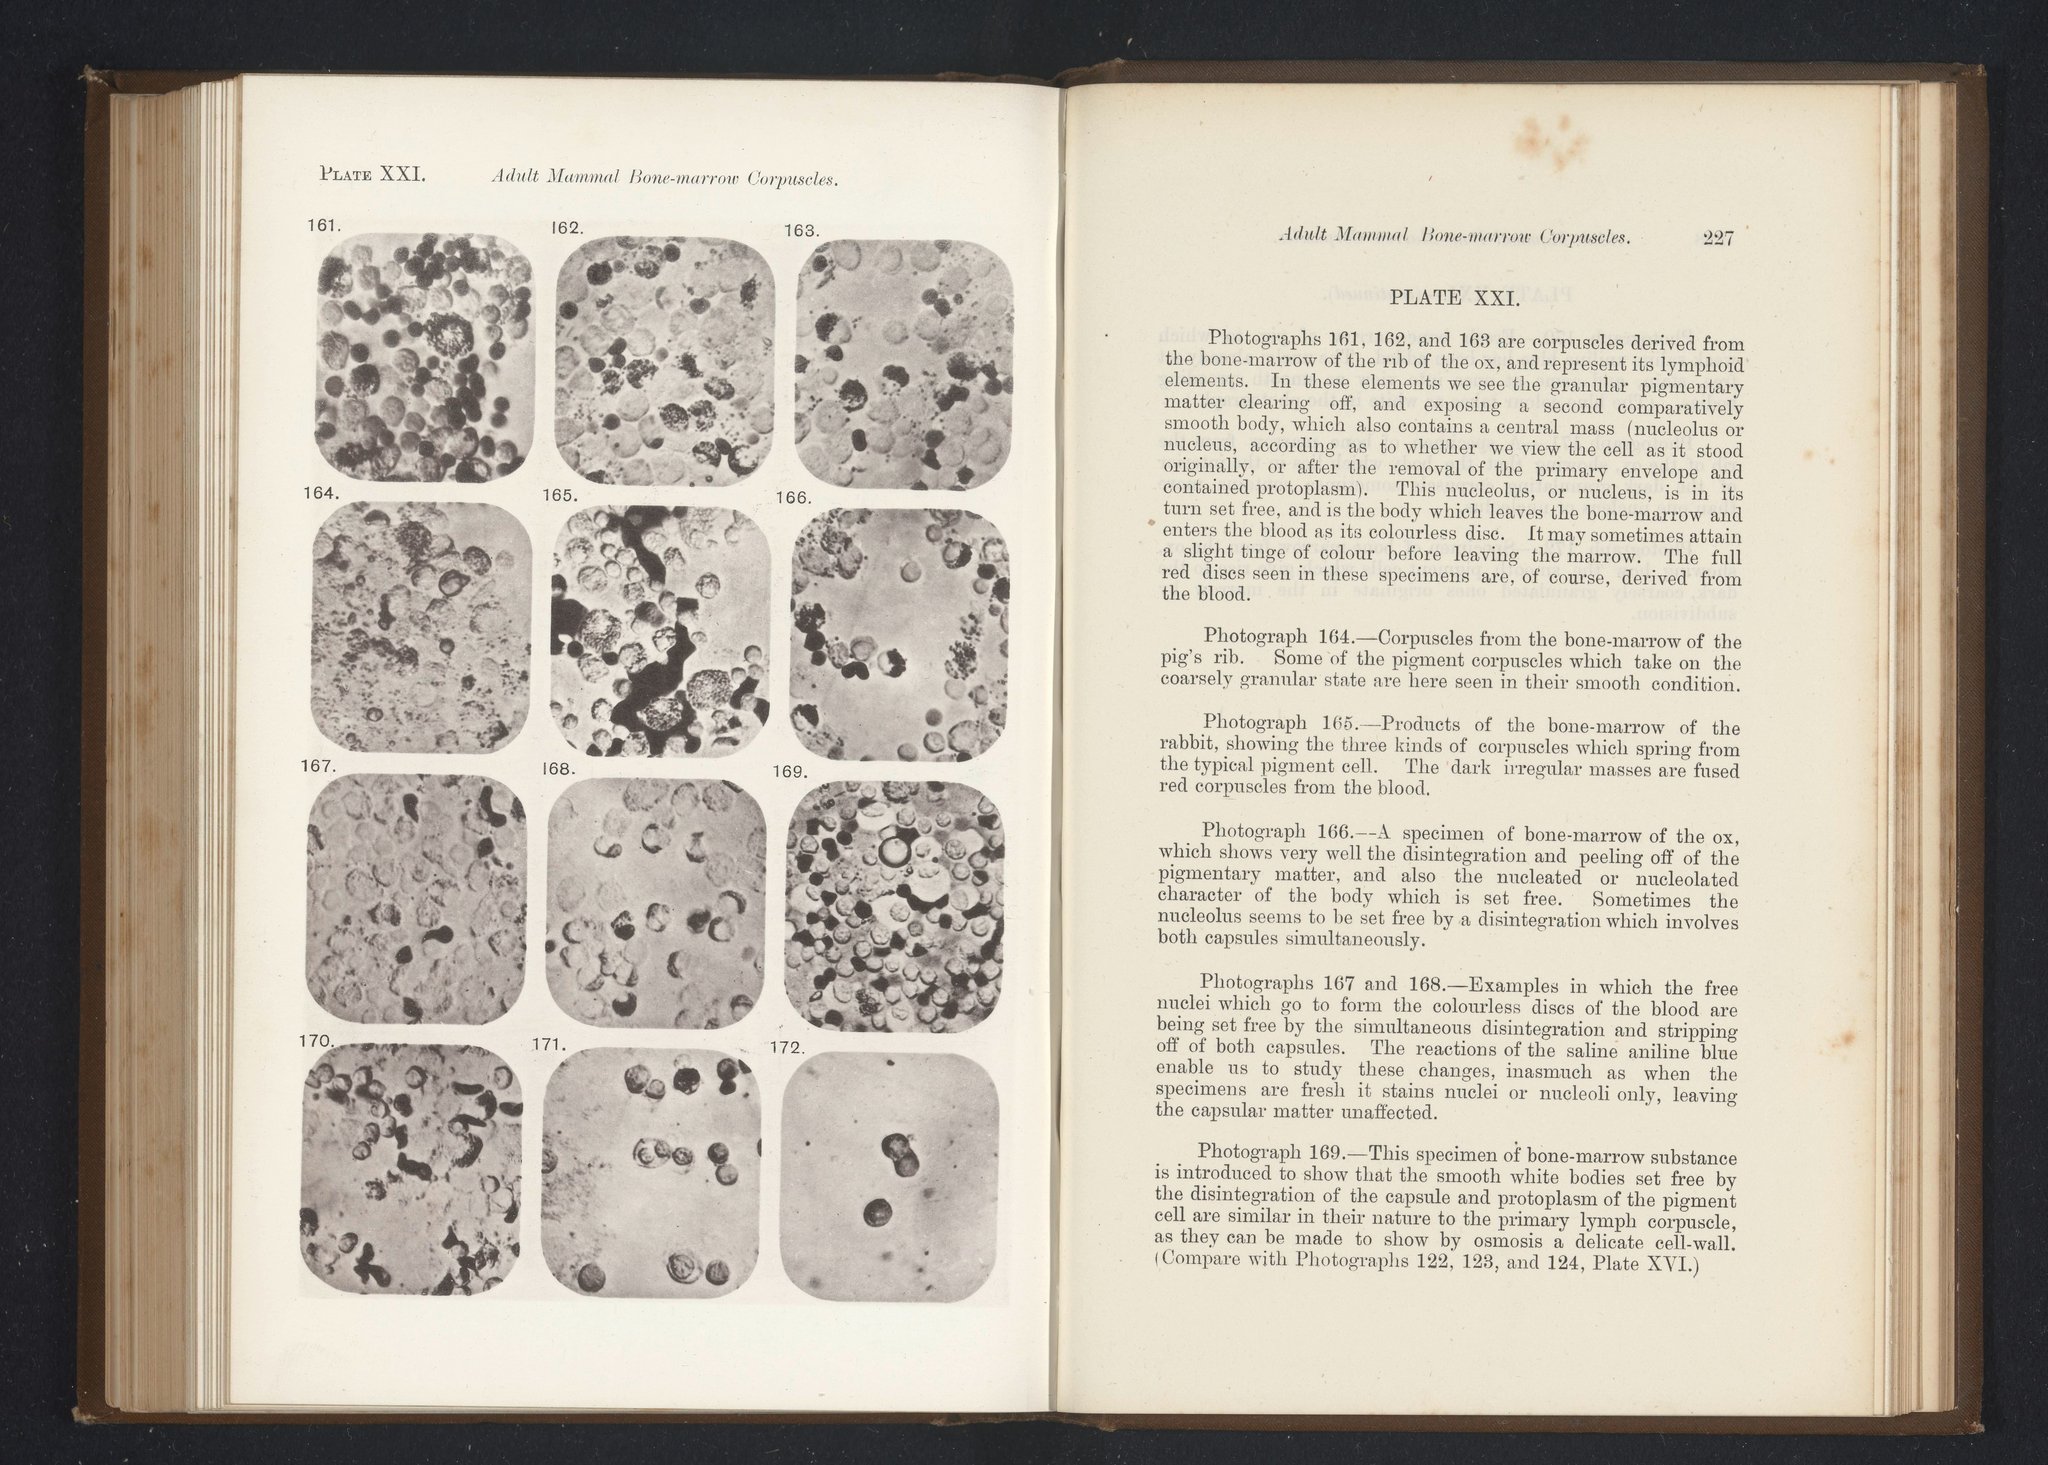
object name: photomechanical print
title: Twaalf vergrotingen van bloedlichaampjes in een beenmerg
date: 1872-1882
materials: paper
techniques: photograph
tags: blood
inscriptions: number: ‘Photo. 161. (...) Photo. 172.’, number: ‘Pl. XXI.’